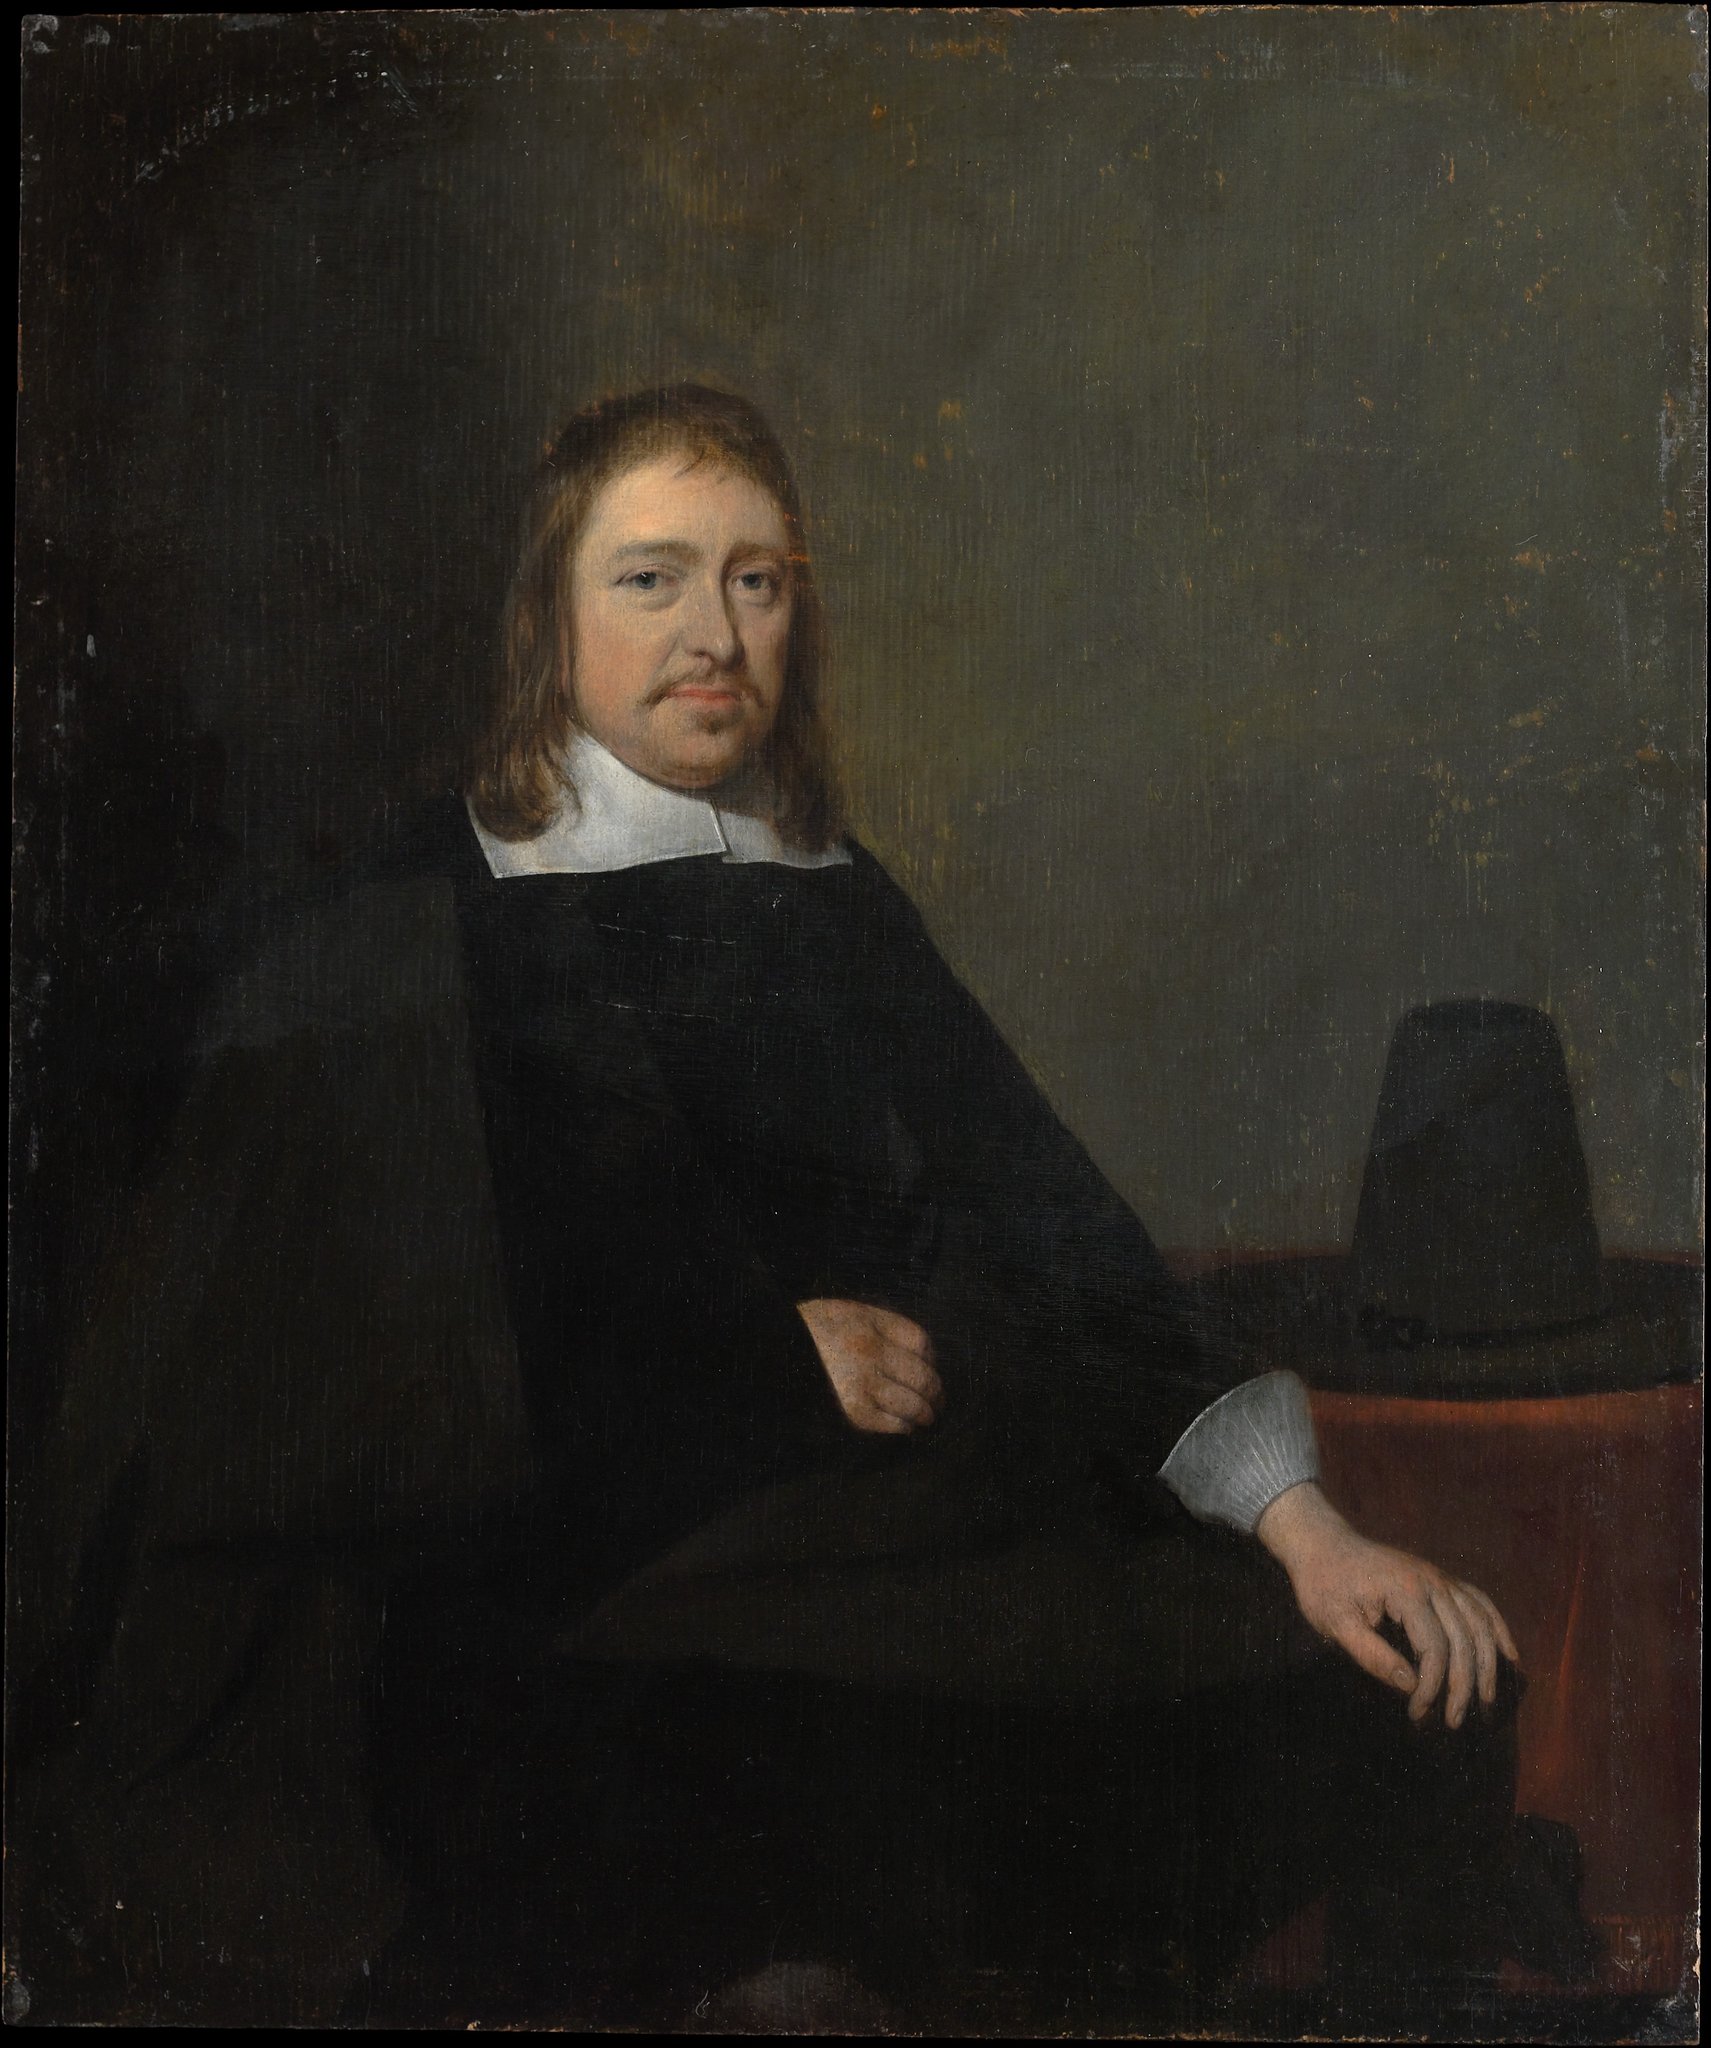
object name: painting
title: Portrait of a Seated Man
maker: gerard ter borch the younger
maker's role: artist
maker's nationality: dutch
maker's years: 1617-1681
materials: oil, wood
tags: men,portraits